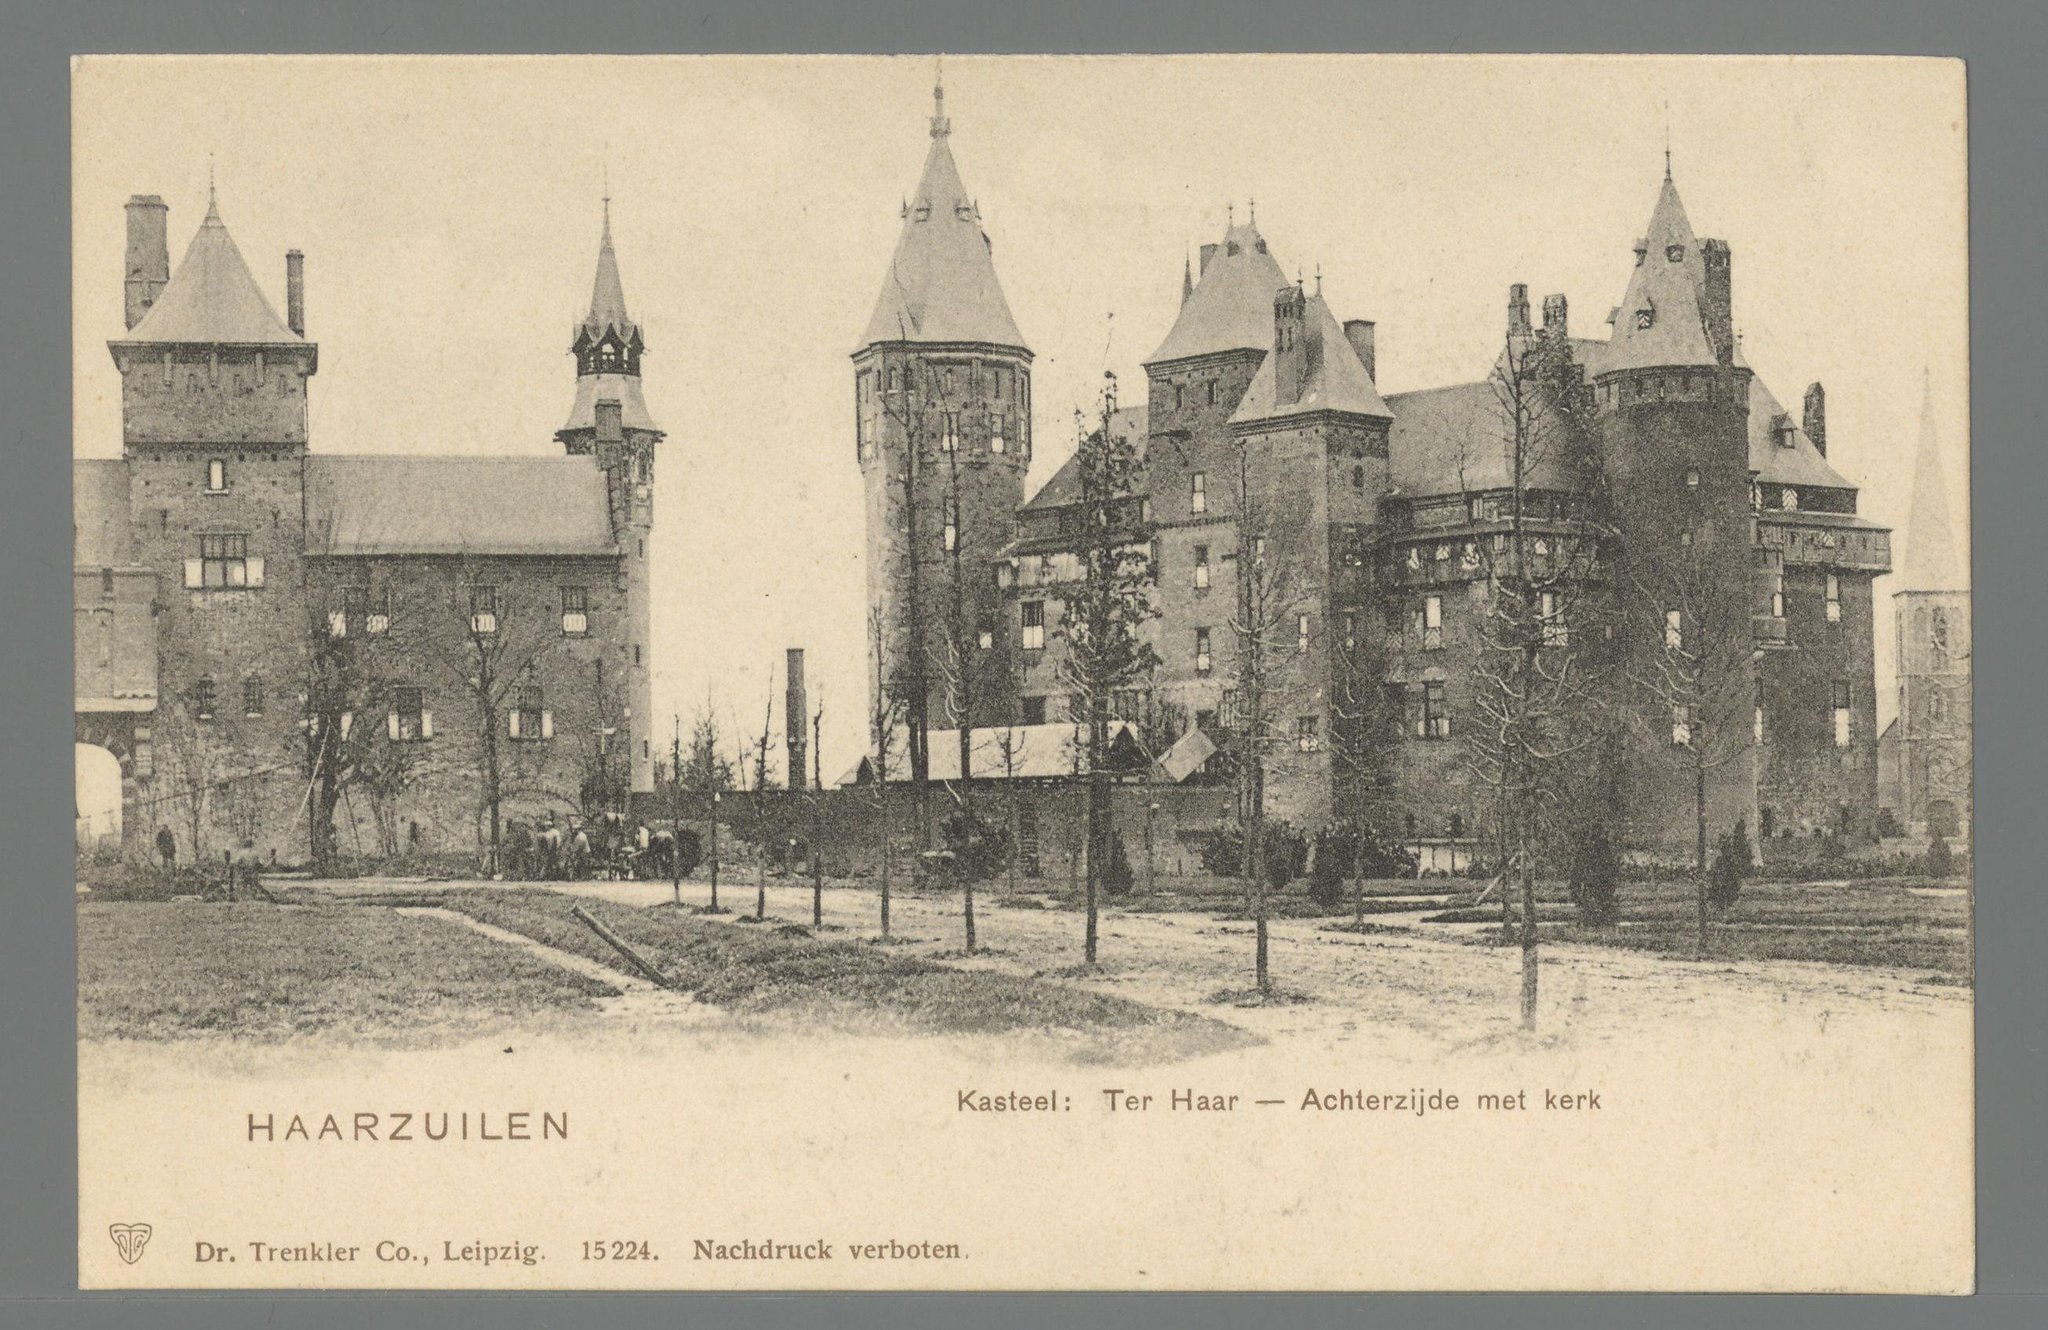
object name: ansichtkaart, prentbriefkaart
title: Haarzuilen. Kasteel: Ter Haar - Achterzijde met kerk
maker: Anonymous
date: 1897-1905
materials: cardboard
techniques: photograph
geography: leipzig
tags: castle, church (exterior)